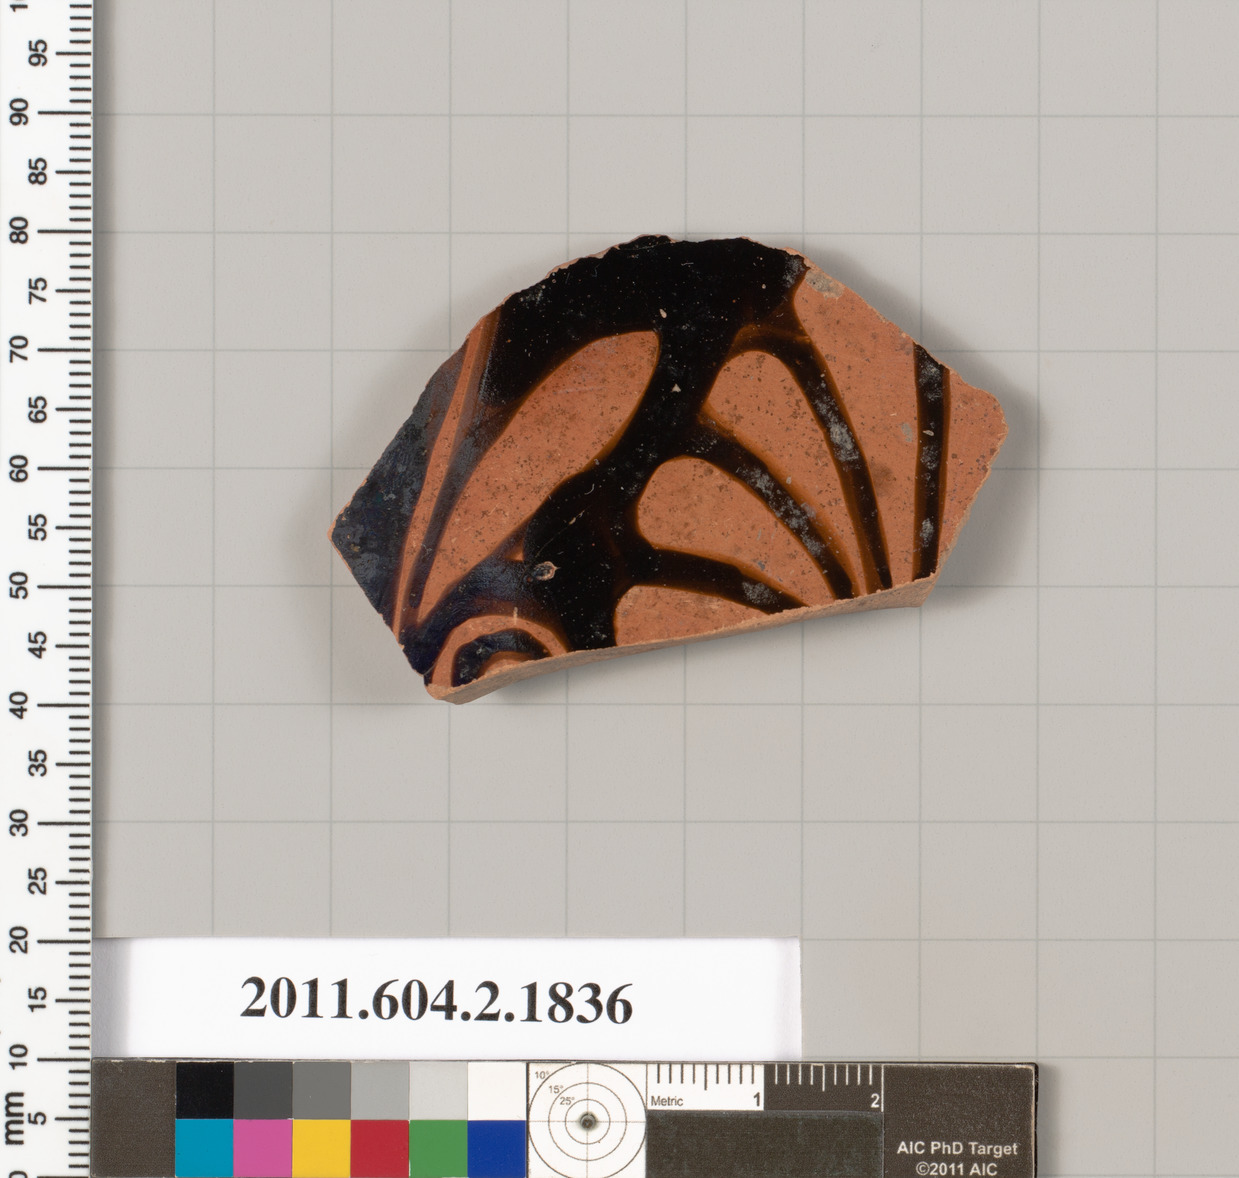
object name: skyphos fragment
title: Terracotta fragment of a skyphos (deep drinking cup)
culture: greek, attic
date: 450-426 BCE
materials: terracotta